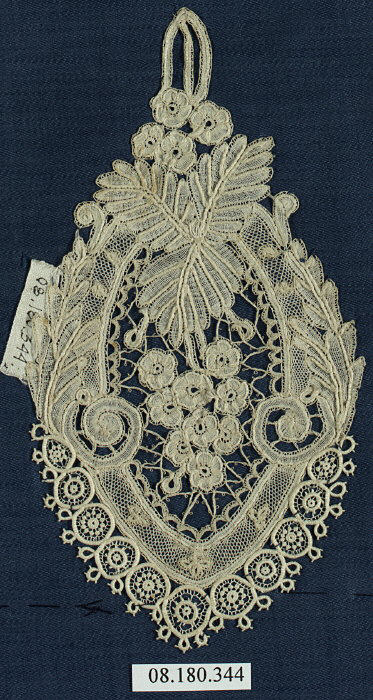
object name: ornament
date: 1801-1900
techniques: lace